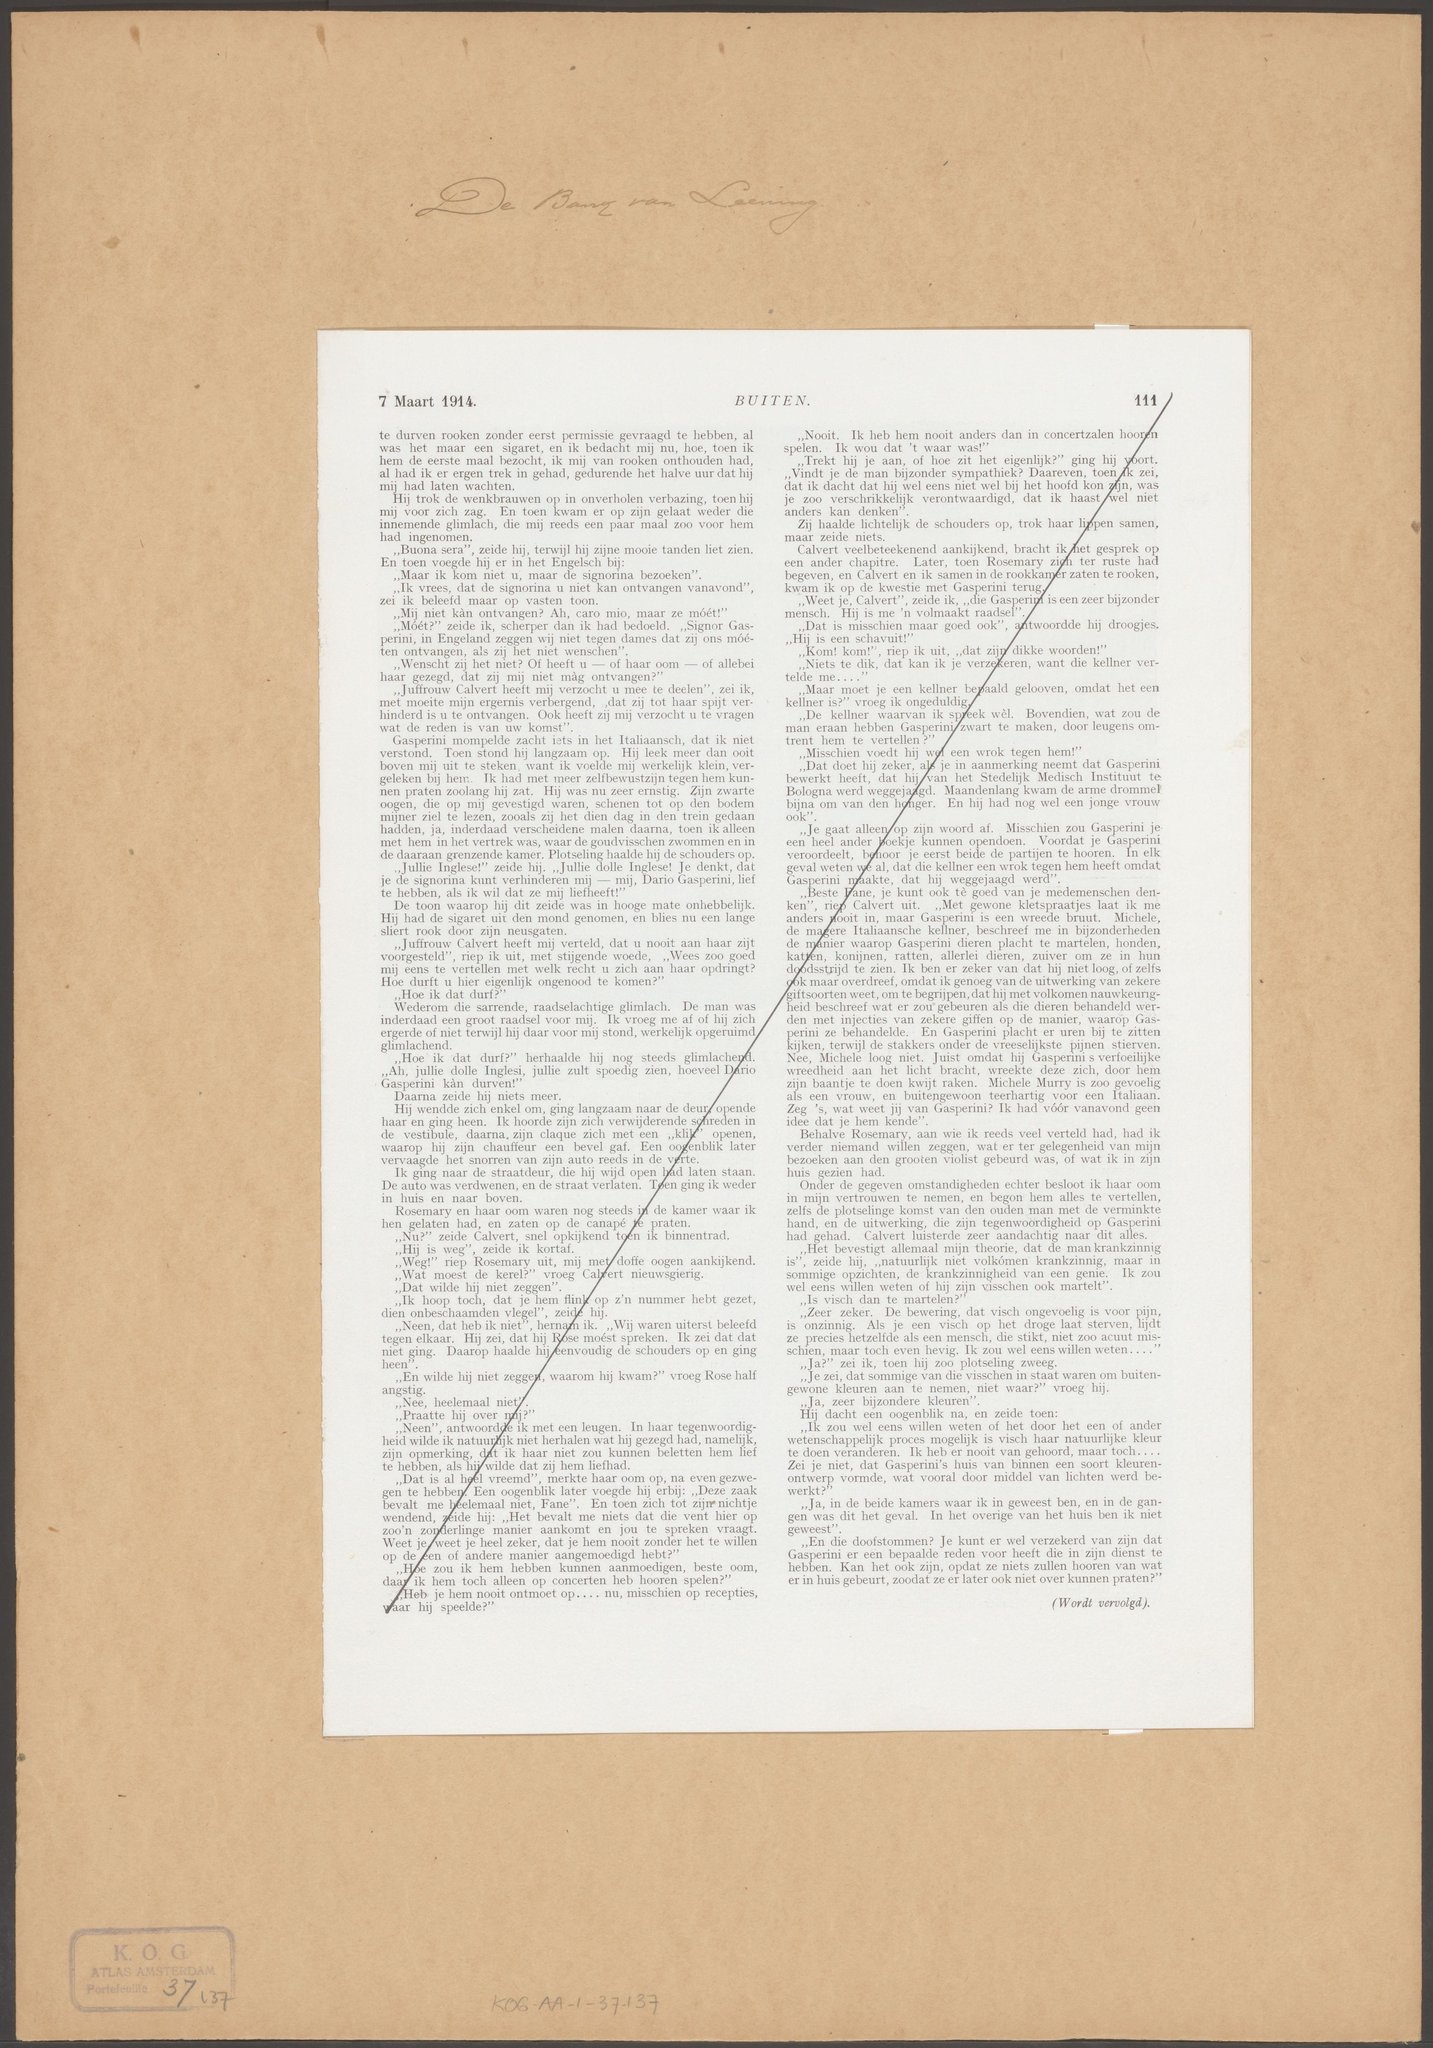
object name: article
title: Artikel over de Stadsbank van Lening te Amsterdam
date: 1914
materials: paper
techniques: letterpress printing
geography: amsterdam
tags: pawnbroker, lombard, window, gate, entrance, bank, canals, waters (in city) (+ city(-scape) with figures, staffage)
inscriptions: collector's mark: Lugt 1641b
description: Object bestaat uit twee aan elkaar geplakte bladen. Fotomechanische afdrukken op pagina 112-114. Onderwerpsrubriek binnen de Atlas Amsterdam: Armwezen en liefdadige instellingen: I. Lombard of Bank van Leening.